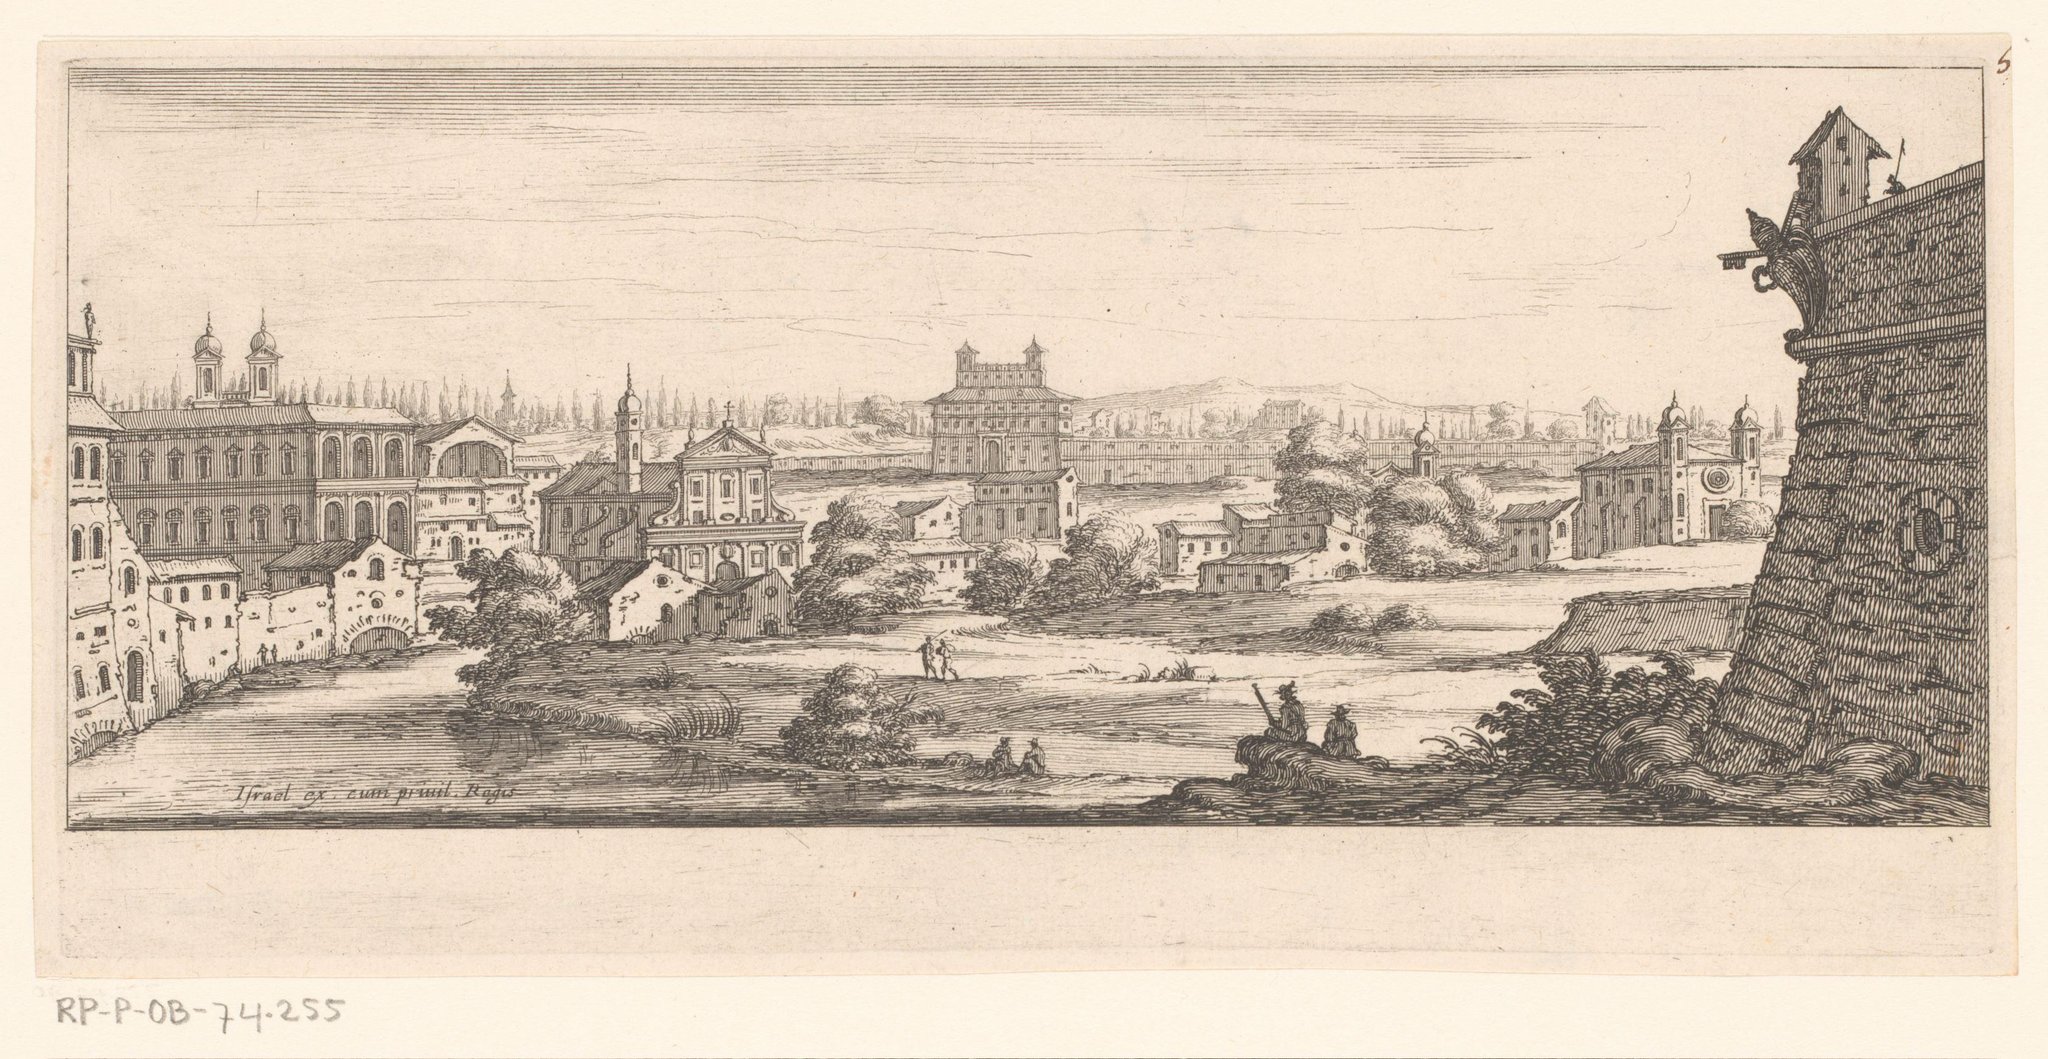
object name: print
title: Gezicht op Rome met op de voorgrond een vlakte met enige mensen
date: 1631-1661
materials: paper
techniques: etching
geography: france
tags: landscapes, rome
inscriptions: collector's mark: Lugt 240